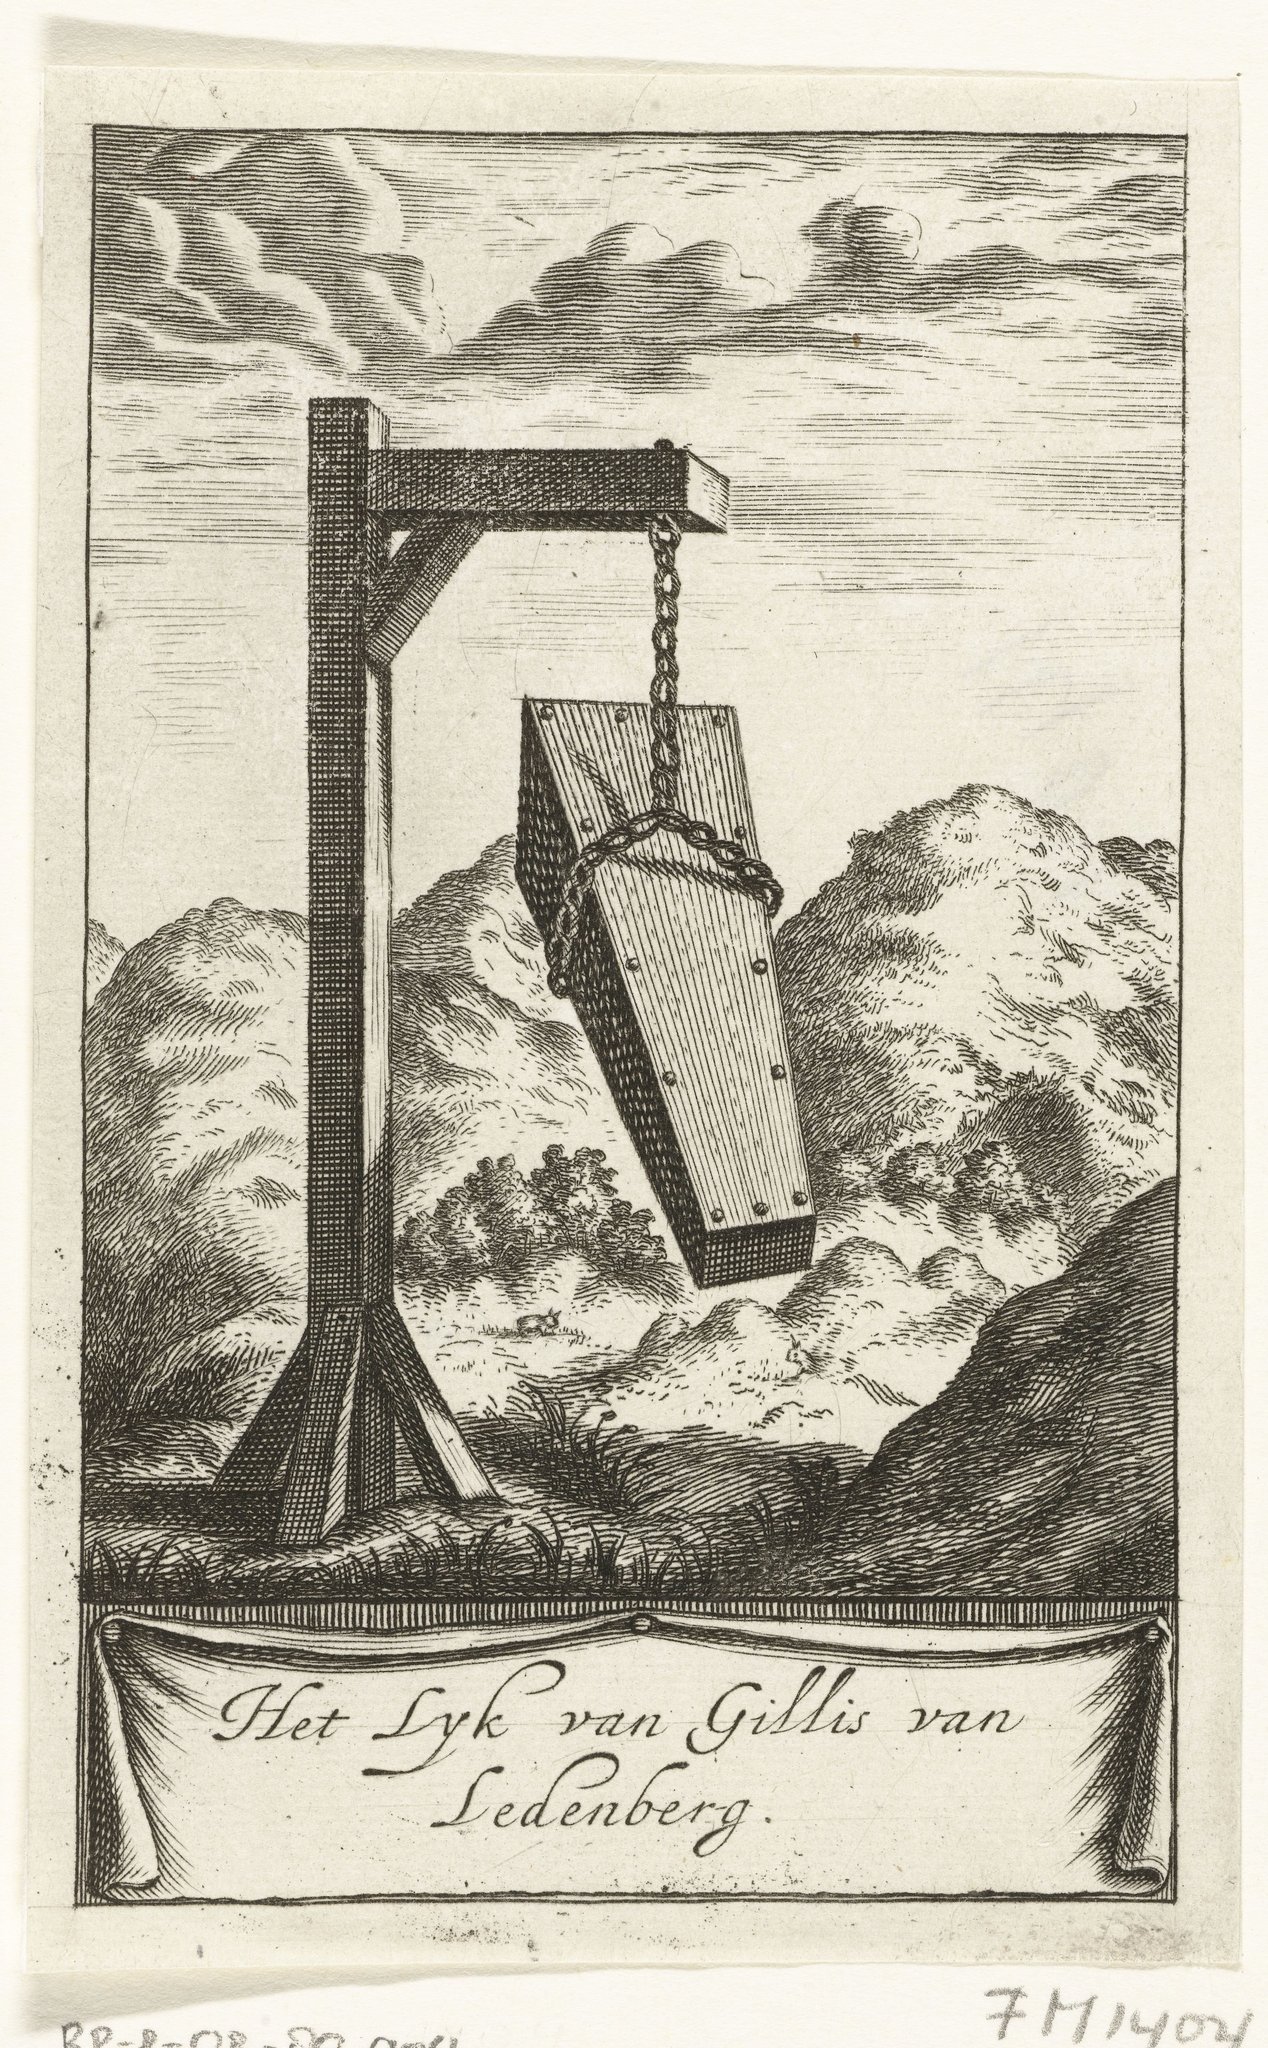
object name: history print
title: Het Lyk van Gillis van Ledenberg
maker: Anonymous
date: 1619-1699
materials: paper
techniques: engraving, etching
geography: northern netherlands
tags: utrecht, violent death by hanging, seeking death, suicide, the hague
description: De kist met de overblijfselen van Gilles van Ledenberg hangend aan de galg in de duinen buiten Den Haag, 15 mei 1619.